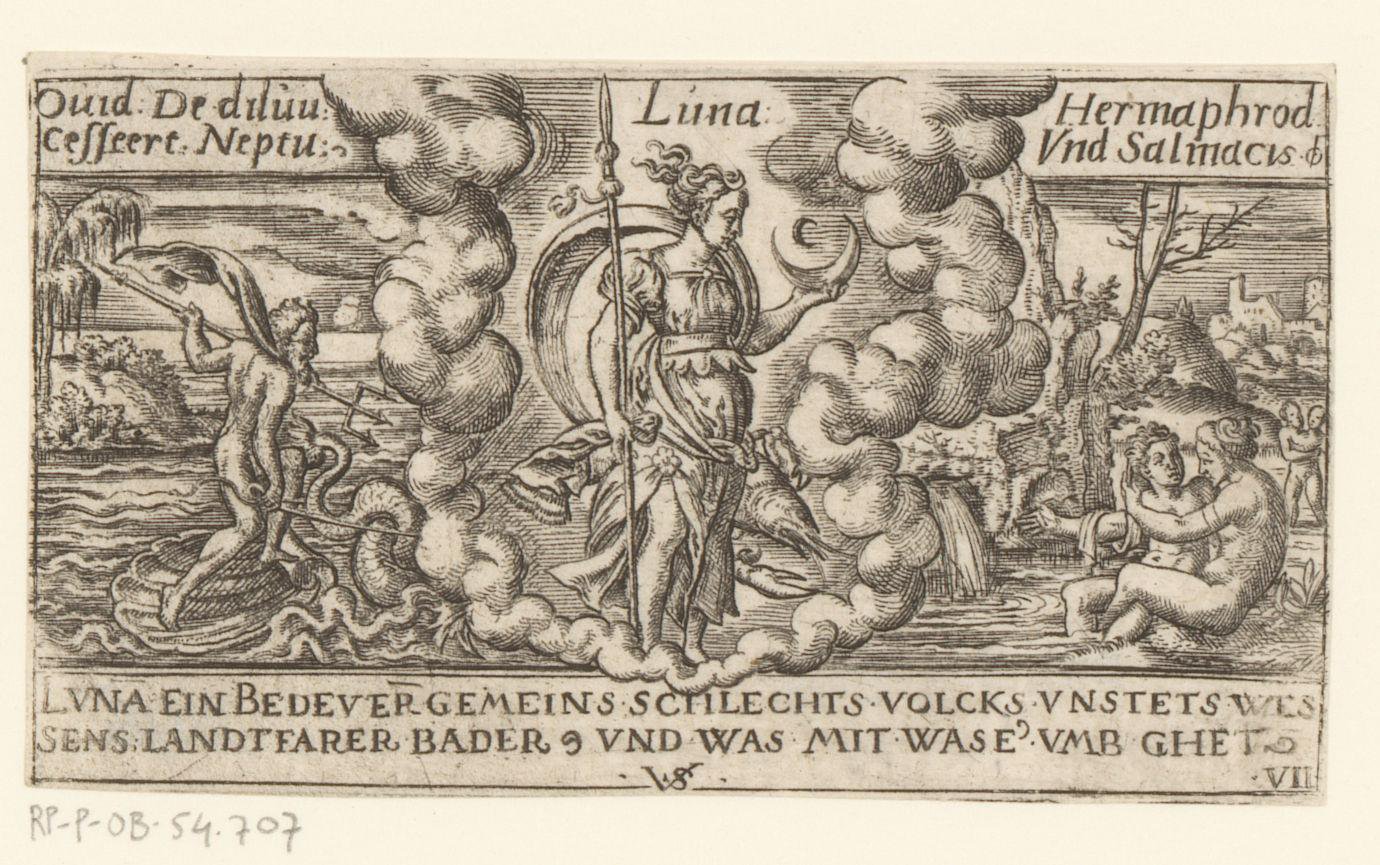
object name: print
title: Luna met een Kreeft (teken van de dierenriem)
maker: virgilius solis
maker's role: draughtsman, print maker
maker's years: 1514-1562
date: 1524-1562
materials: paper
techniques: engraving, etching, intaglio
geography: nuremberg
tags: cancer (zodiacal sign of june), diana as moon-goddess, i.e. luna (selene), chariot, triumphal car, moon as celestial body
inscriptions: collector's mark: Lugt 2228, number: ‘52’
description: Maakt deel uit van een serie van zeven prenten met personificaties van de planeten, tekens van de dierenriem en verbeeldingen van verhalen uit de Metamorfosen van Ovidius.